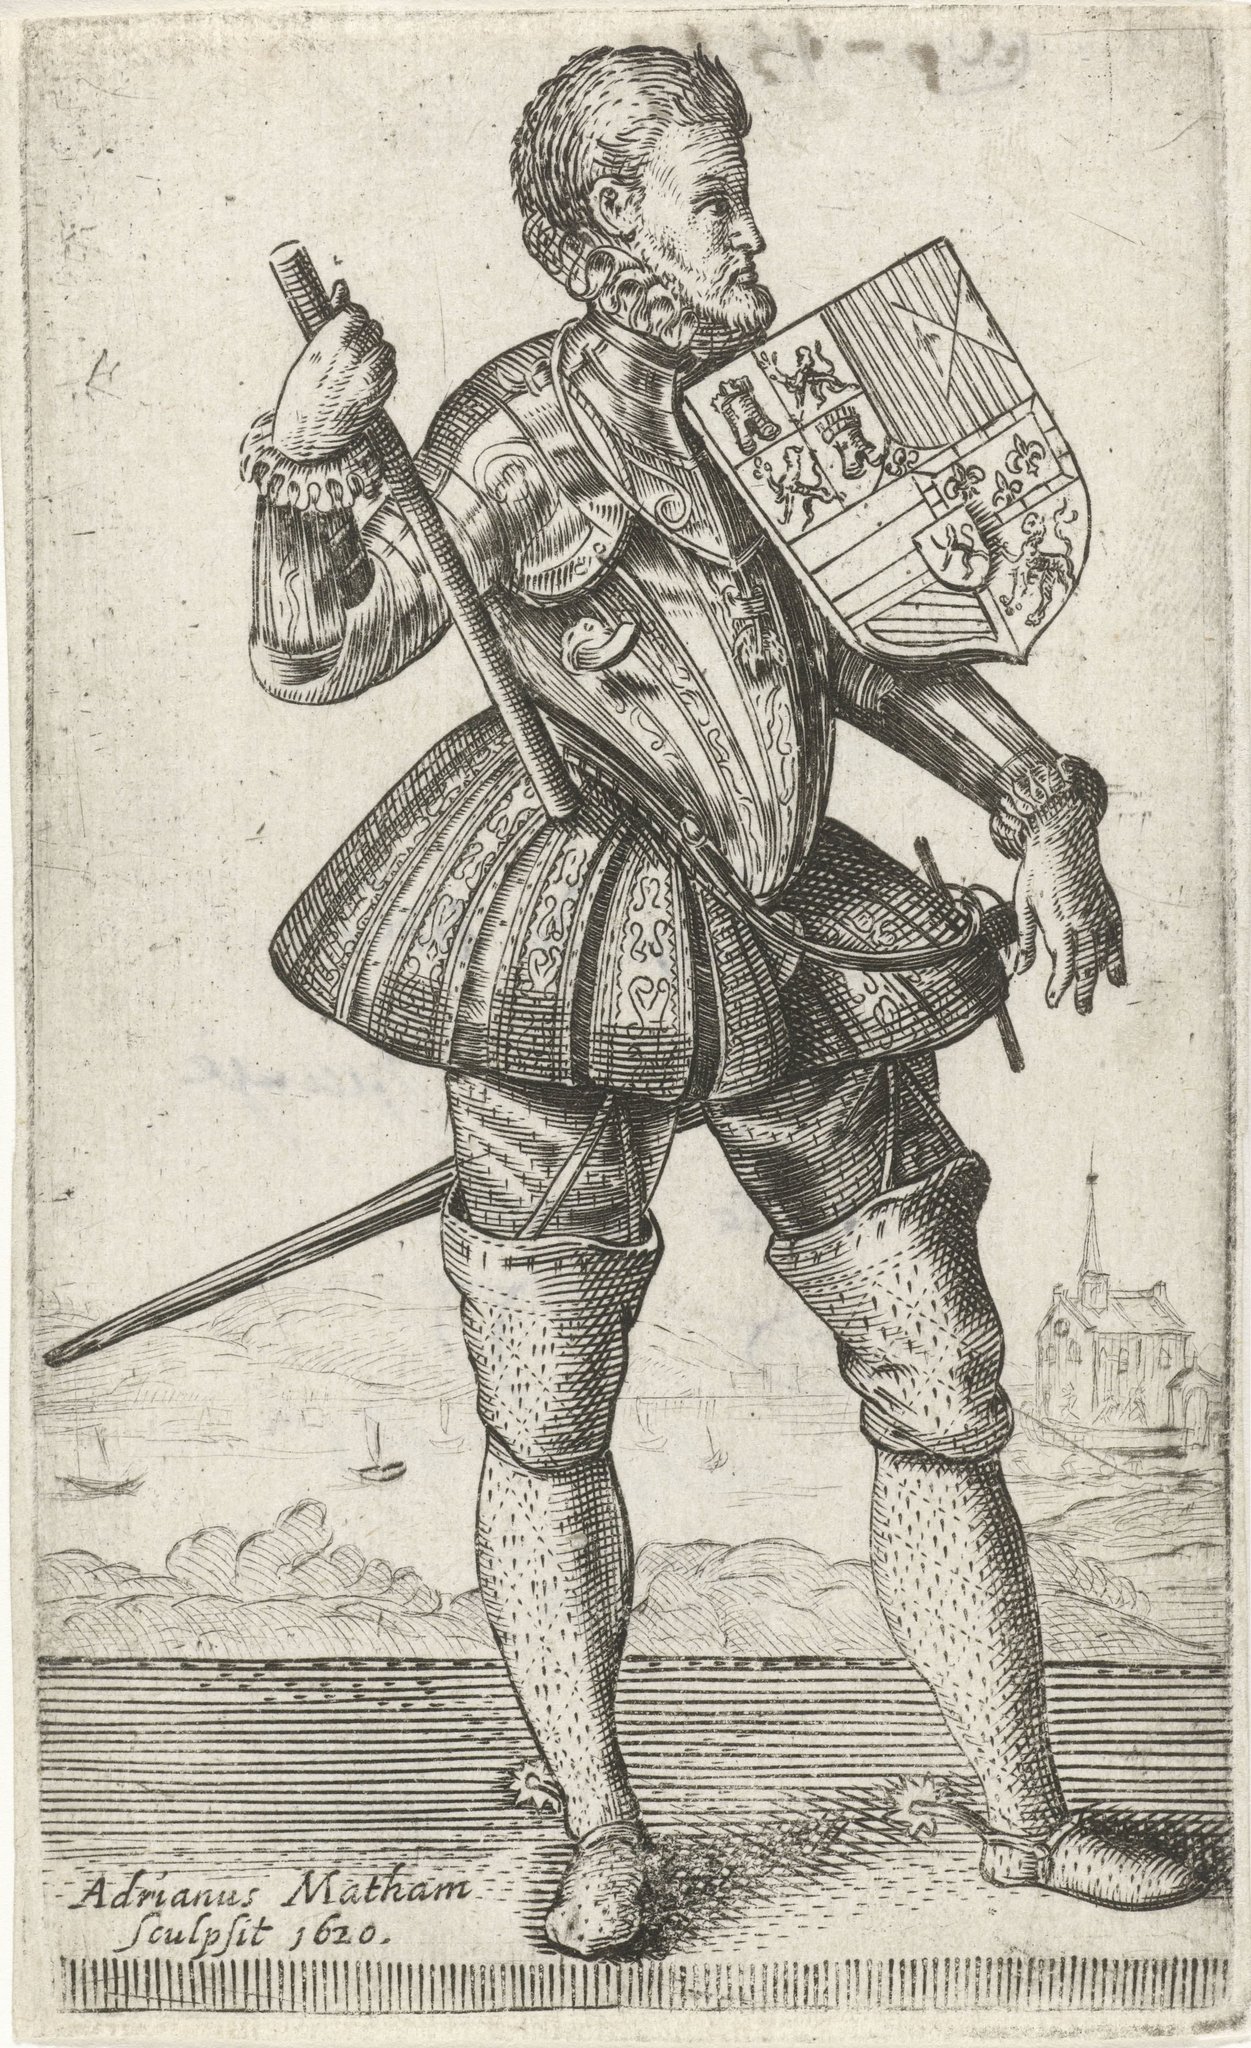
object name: print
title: Graven en gravinnen van Holland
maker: adriaen matham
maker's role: draughtsman, print maker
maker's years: 1599-1660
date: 1620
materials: paper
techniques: drypoint, engraving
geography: haarlem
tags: filips iii (koning van spanje), historical persons, nobility and patriciate; chivalry, knighthood, county of holland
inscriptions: number: ‘1549(?)’, name: ‘Philip de tweede/ koning van spanje/ 31ste graaf’, collector's mark: Lugt 2228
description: Portret van Filips III, koning van Spanje, staande naar rechts in een harnas met op zijn schouder een wapenschild en in zijn hand een commandostaf. Prent uit een serie van 36 prenten met portretten ten voeten uit van graven en gravinnen van Holland.